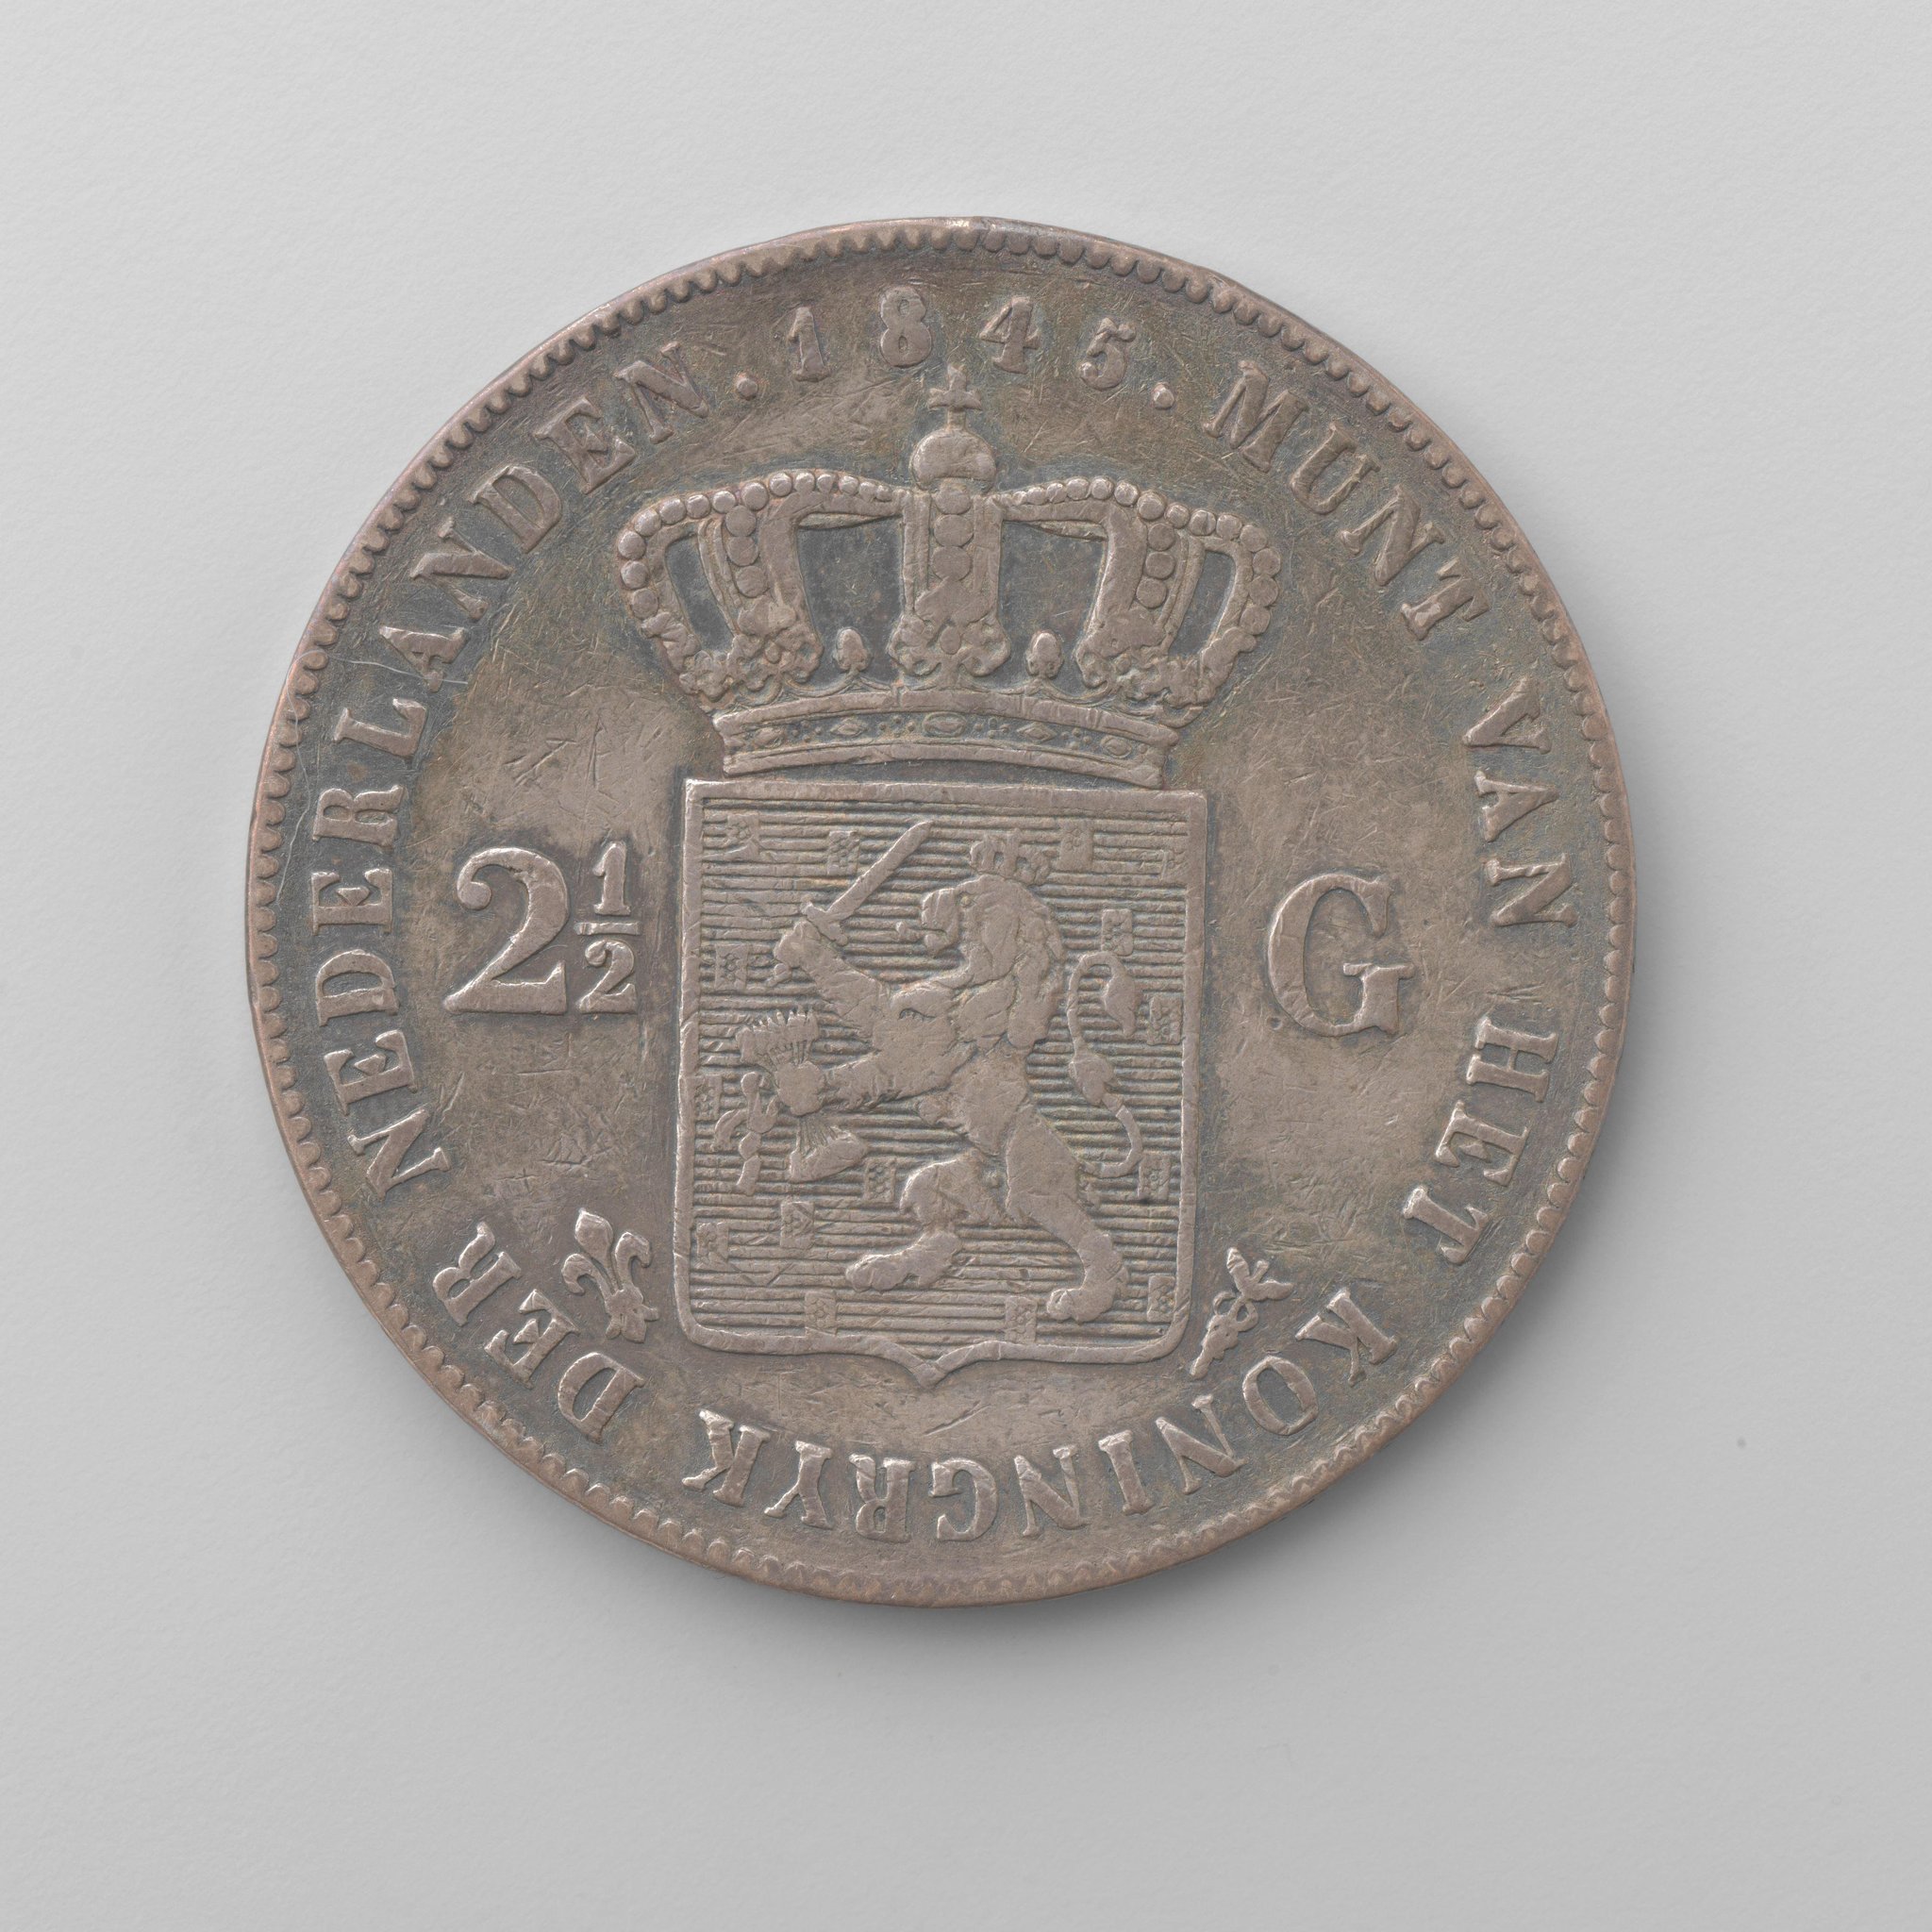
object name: coin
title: Nederlandse 2½ gulden, 1845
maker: william ii of the netherlands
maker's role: koning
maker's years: 1792-1849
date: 1845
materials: silver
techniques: striking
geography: utrecht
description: Zilveren munt. Voorzijde: borstbeeld van koning Willem II naar links. Keerzijde: tussen waarde-aanduiding 2½ G gekroond rijkswapenschild. Jaartal boven kroon. Links onder wapenschild muntmeesterteken: lelie. Randschrift.